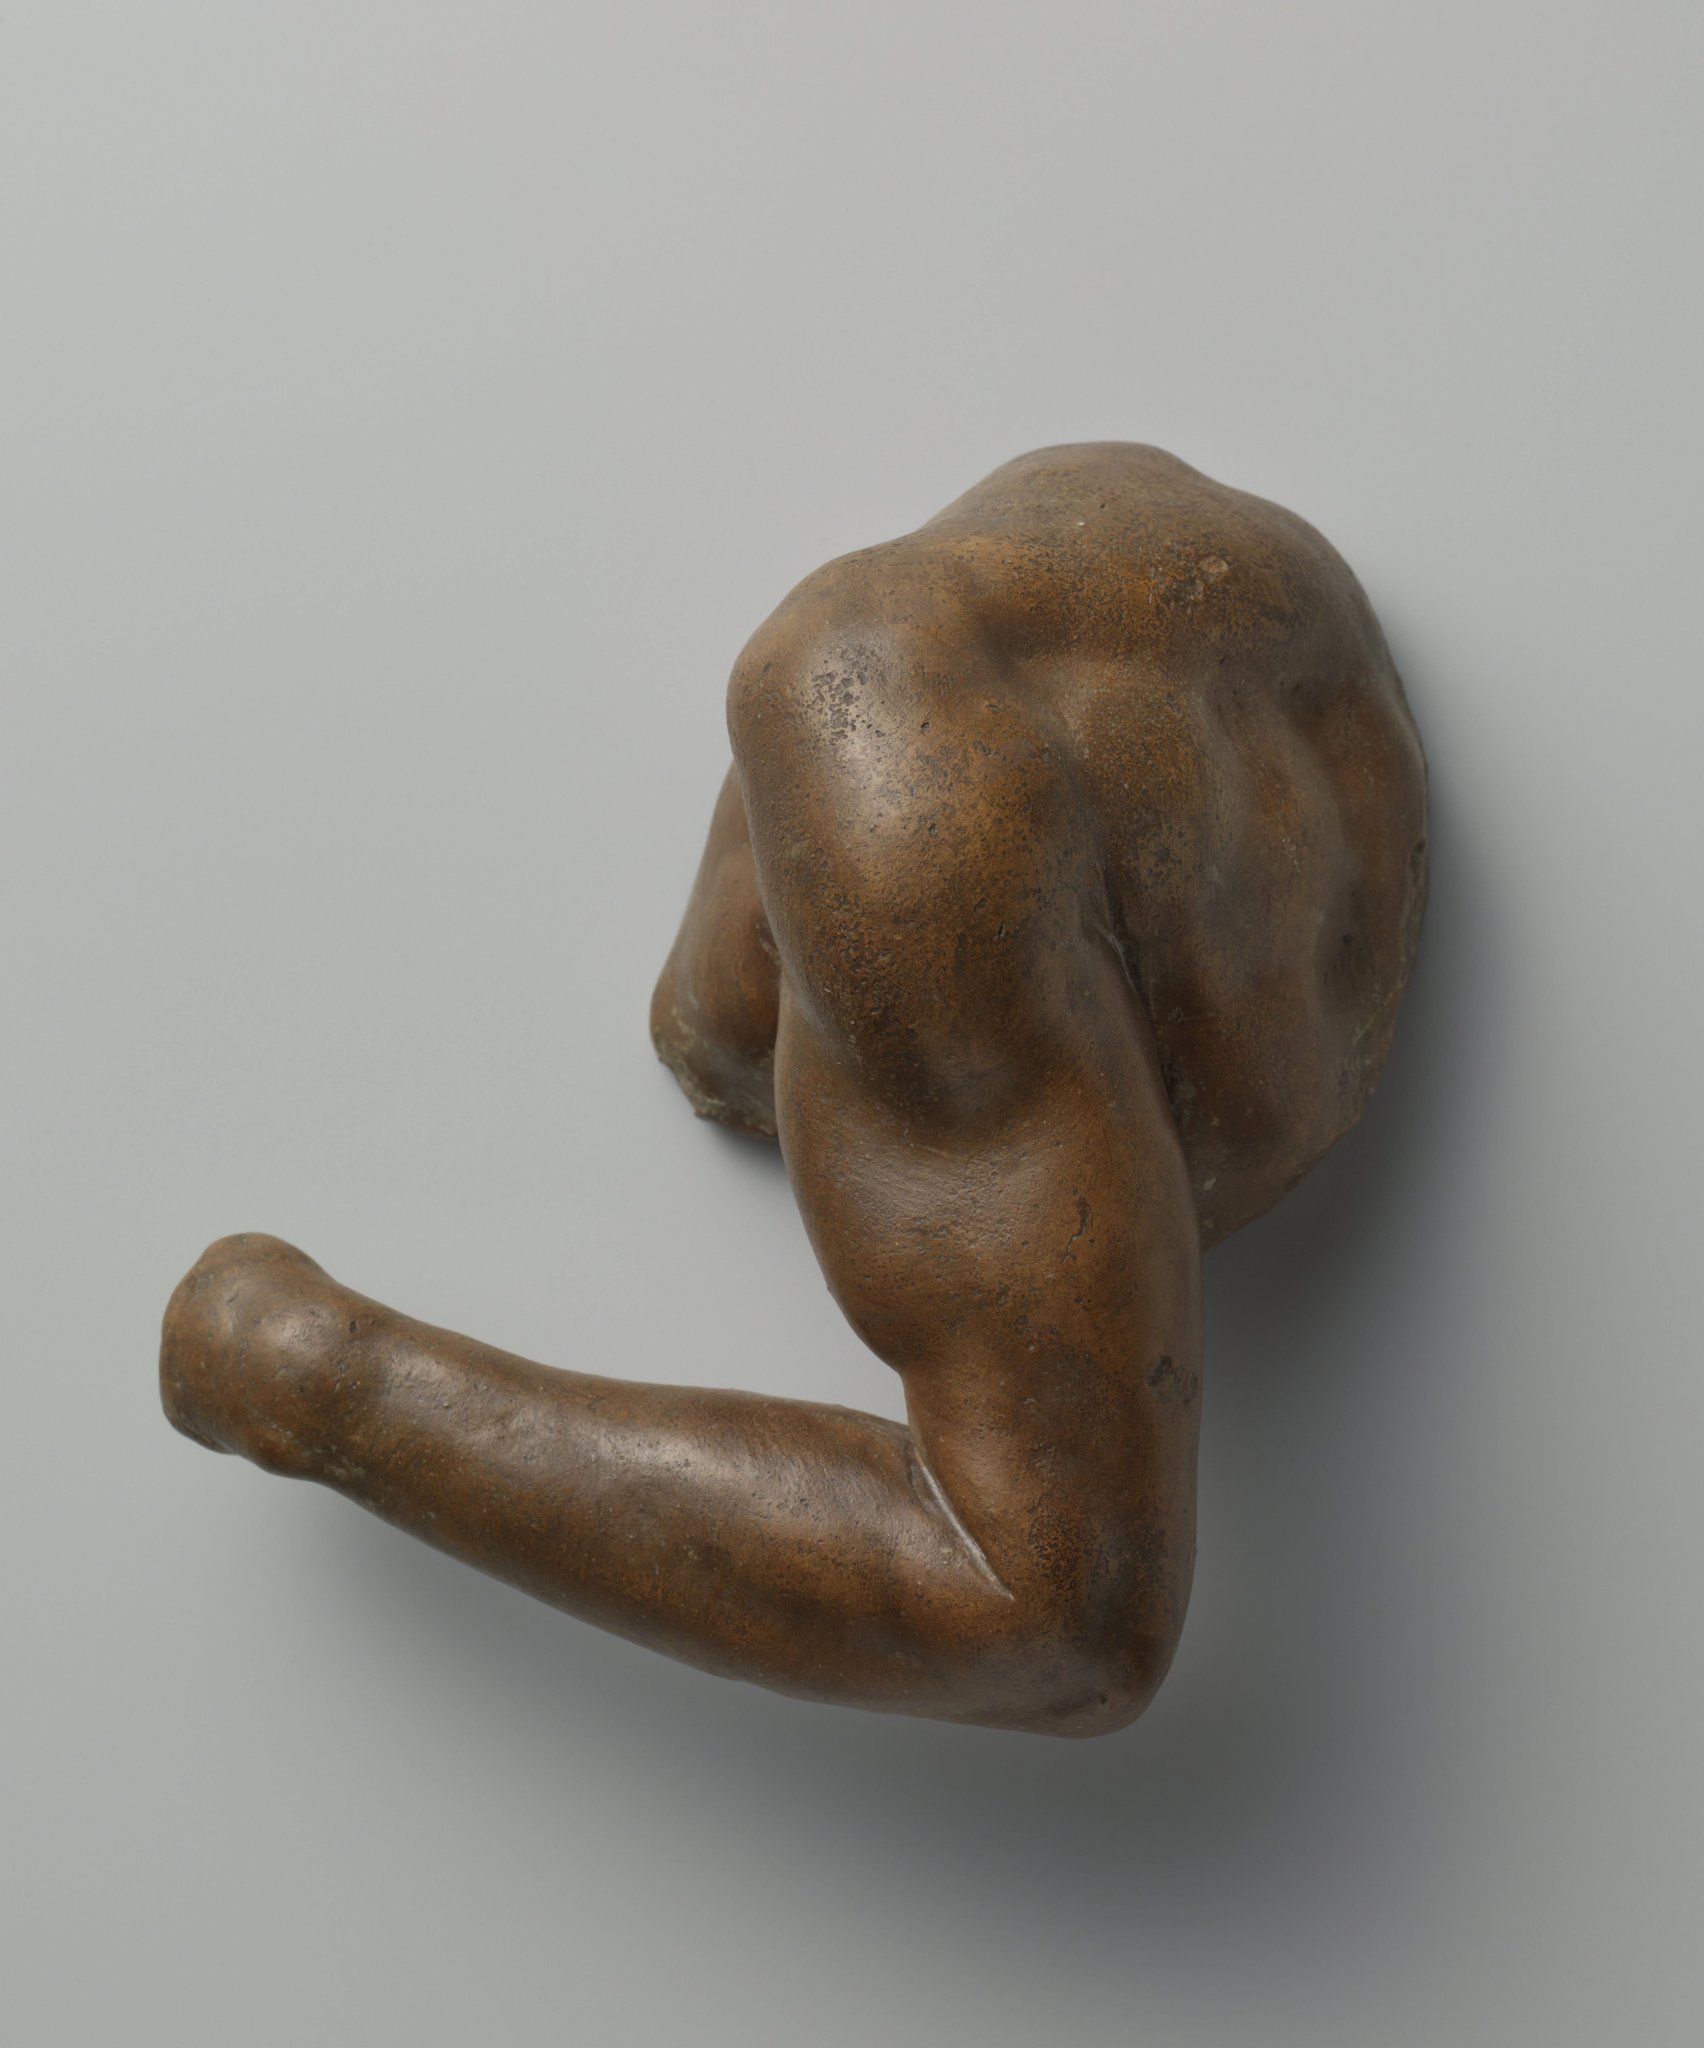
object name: model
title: Sculptor's Model of a Left Arm, Shoulder and a Section of the Back, after Dusk (Medici Chapel, San Lorenzo, Florence)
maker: johan gregor van der schardt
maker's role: sculptor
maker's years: 1530-1581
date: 1560-1570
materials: terracotta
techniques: molding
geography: florence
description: This group of small models of parts of the body are carefully copied after famous sculptures, in particular by Michelangelo, in Florence and Rome. They came from the workshop of the Nijmegen sculptor Johan Gregor van der Schardt, who had a successful career in Italy, Nuremberg, and Copenhagen. They are extremely rare examples of the, in part autograph, study material of a 16th-century sculptor.